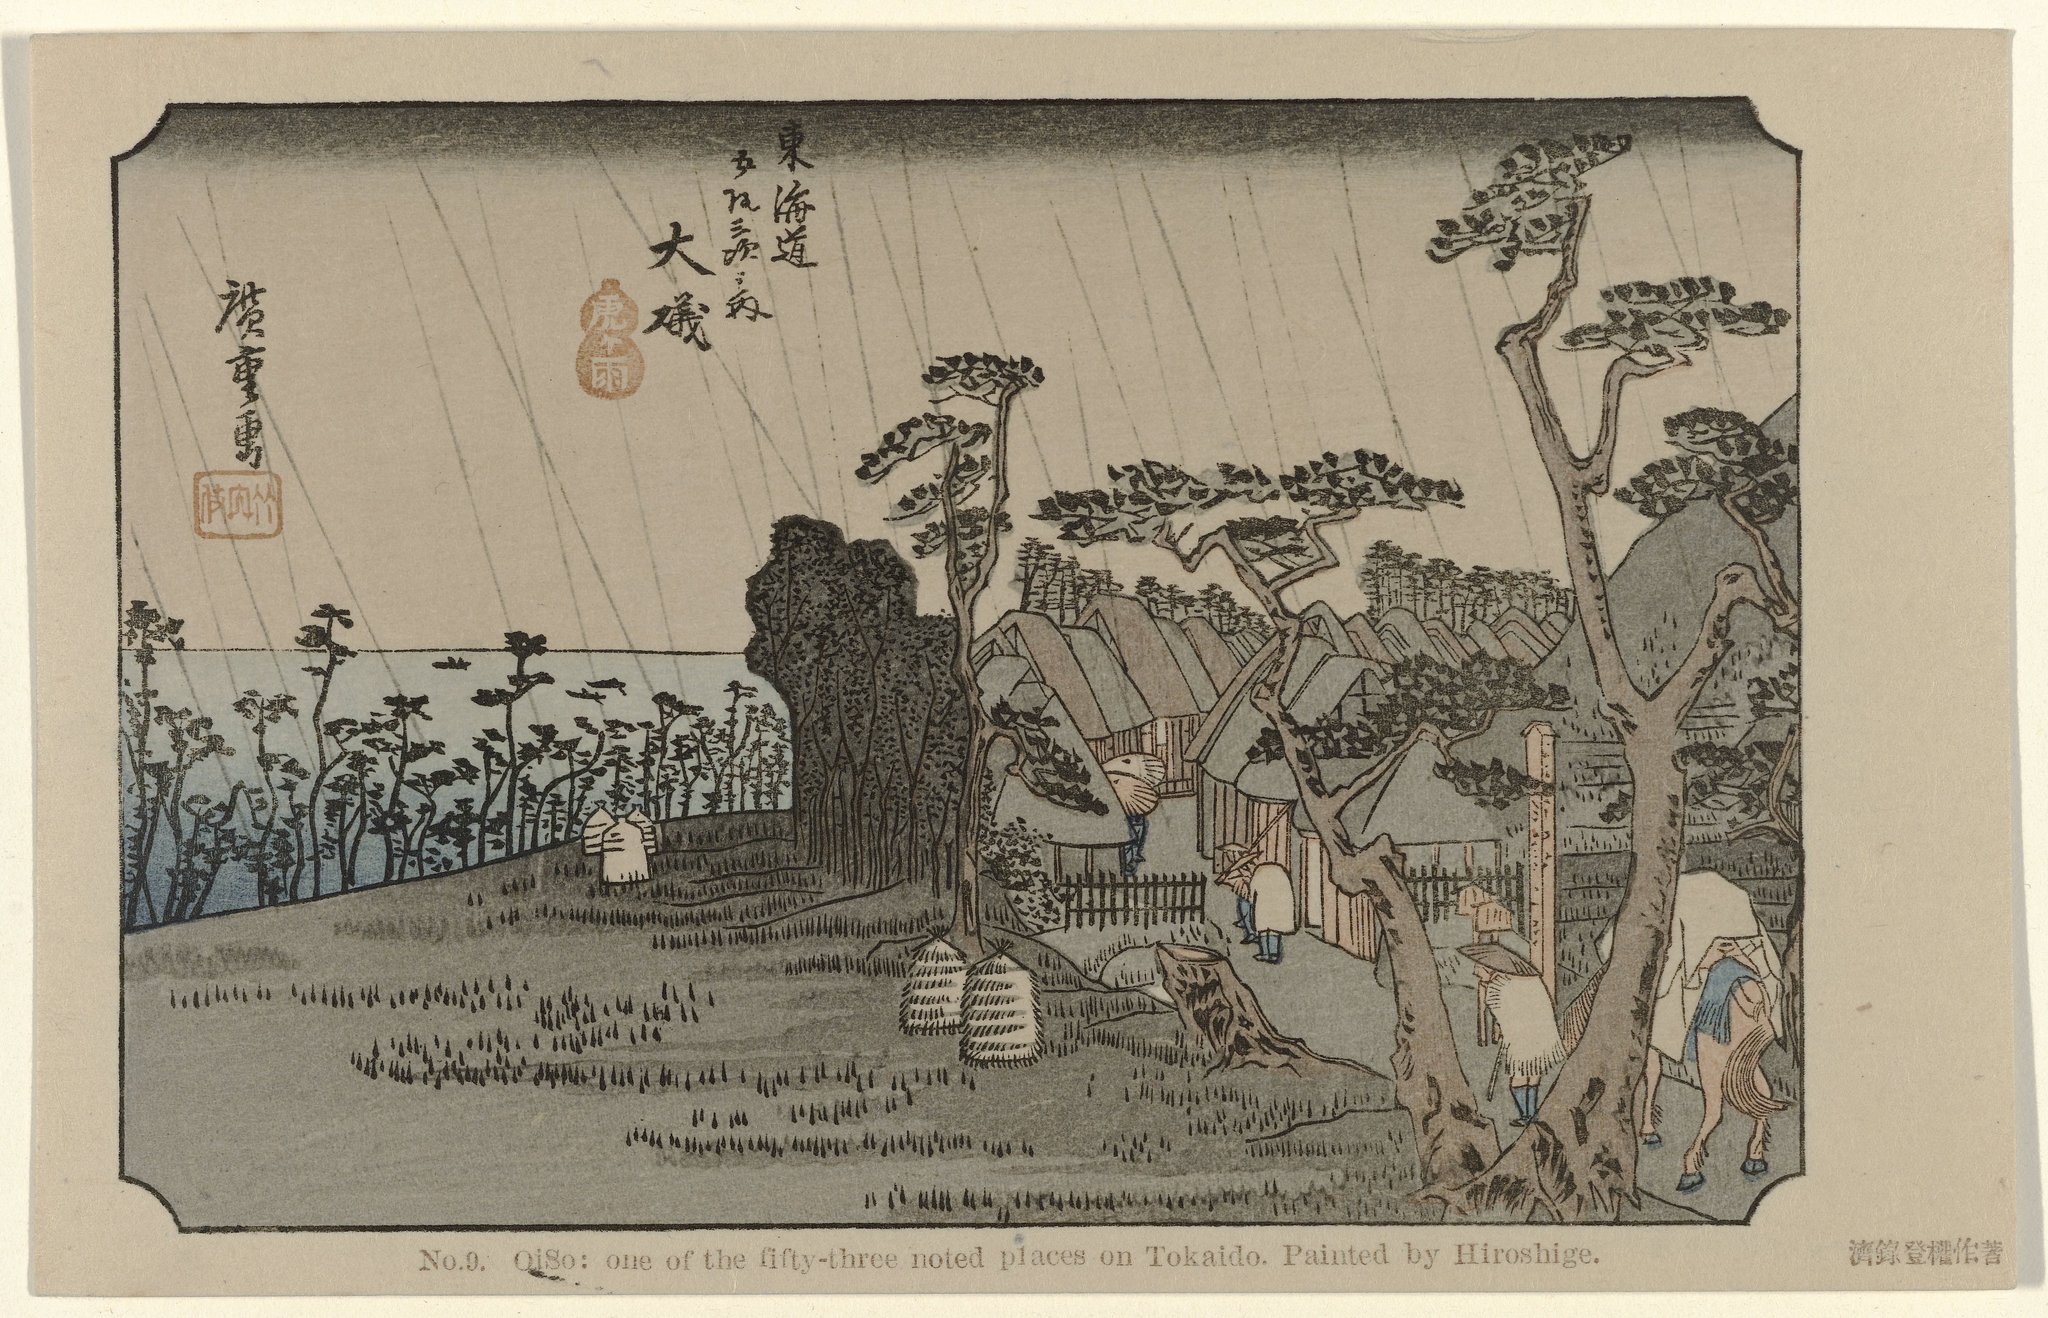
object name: ansichtkaart, prentbriefkaart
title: De Tôkaidô van Hiroshige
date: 1906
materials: cardboard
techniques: woodcut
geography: japan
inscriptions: date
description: Reizigers lopen in de regen richting een smal straatje met hutten, daarachter is de zee zichtbaar.